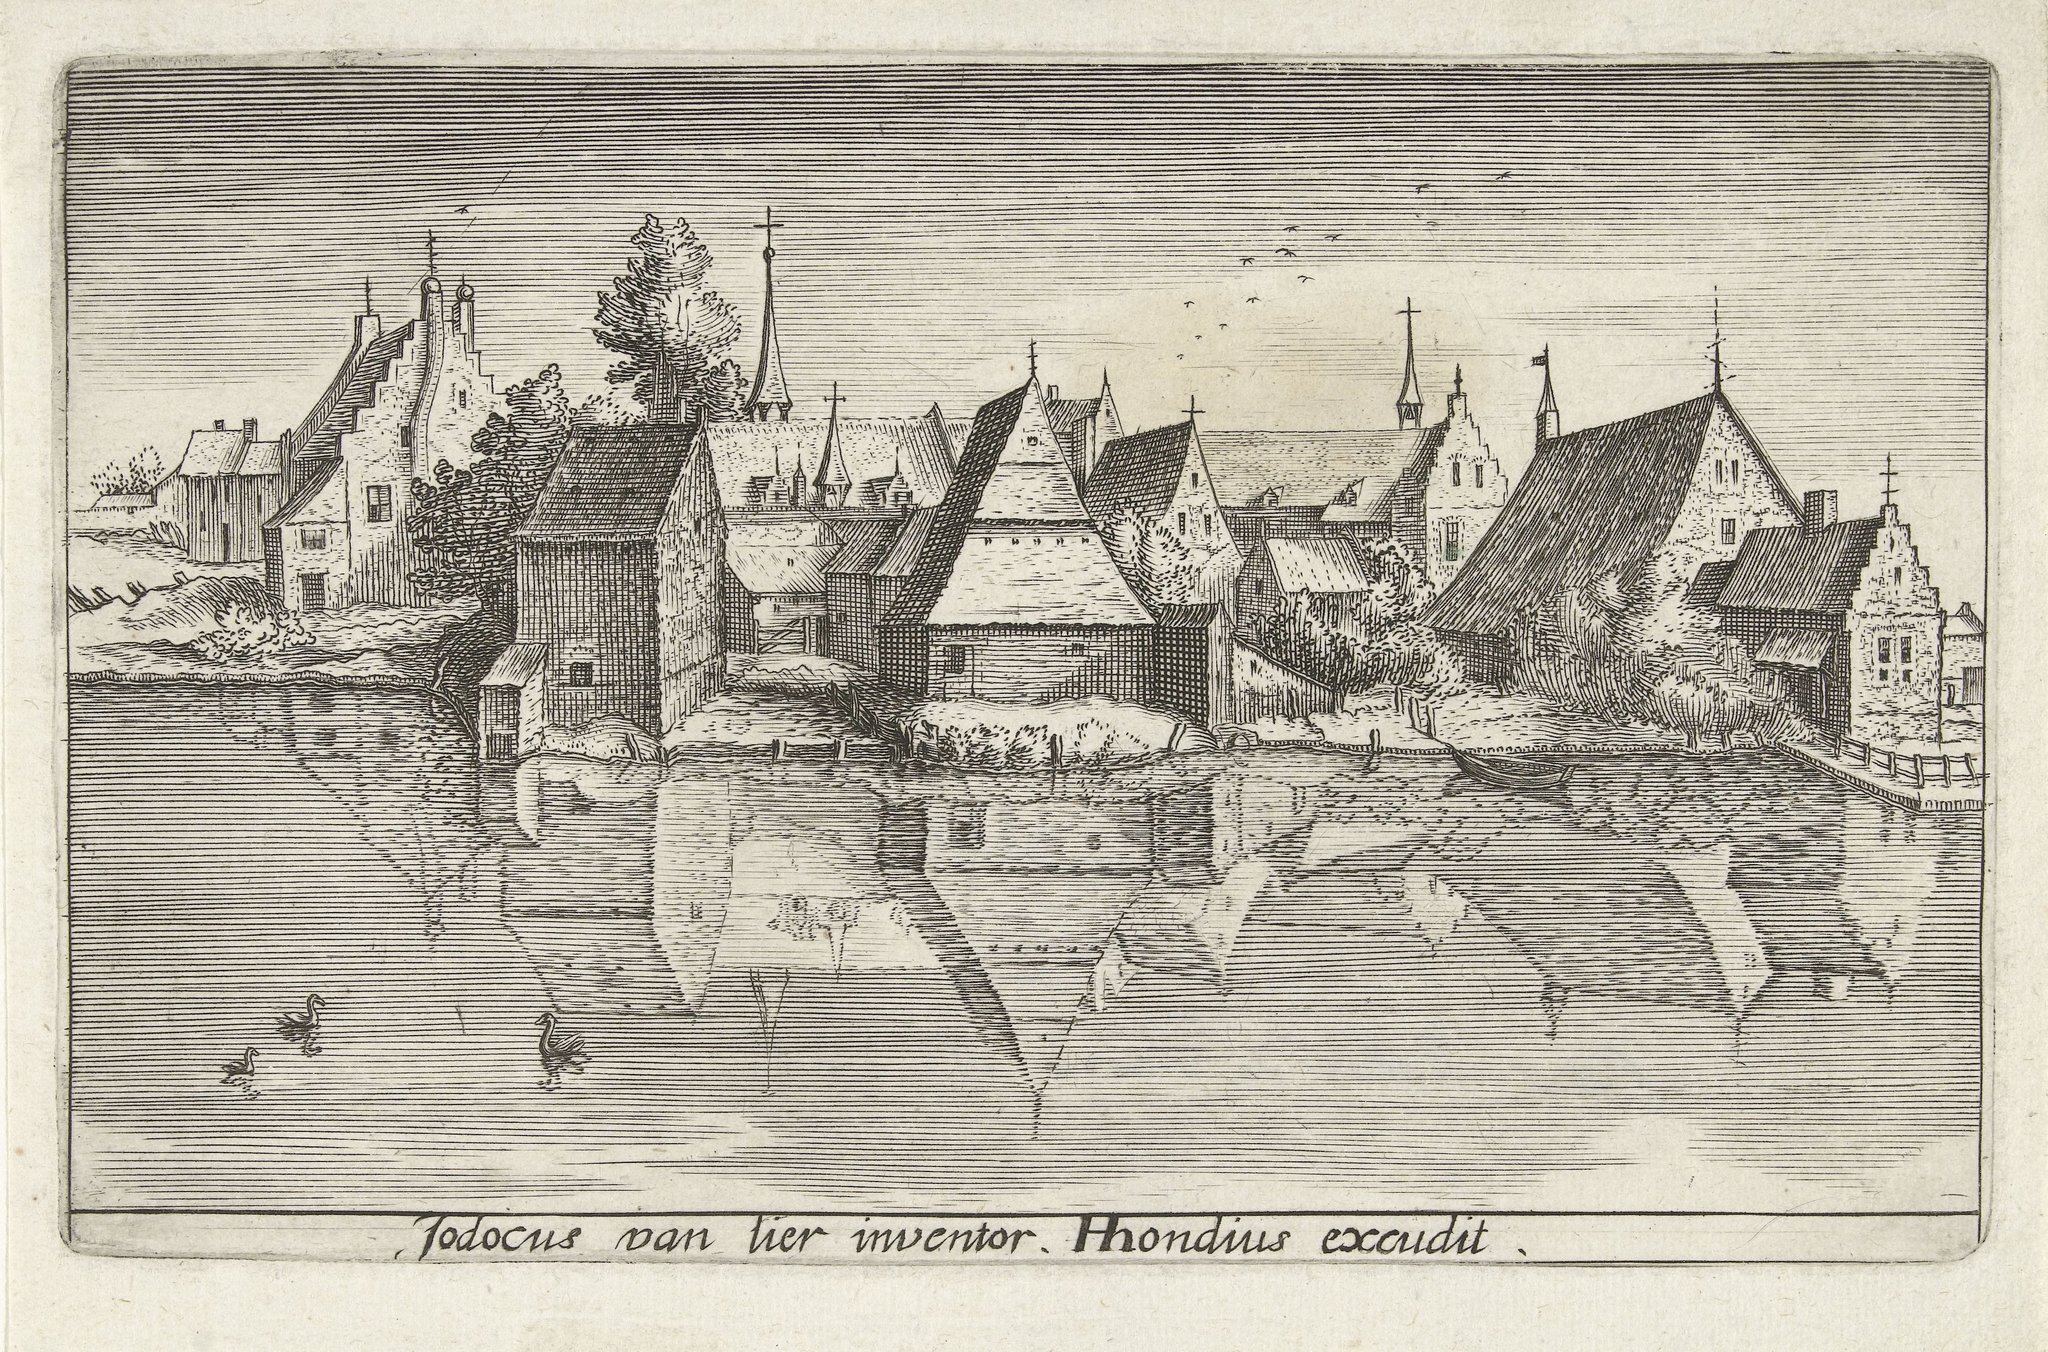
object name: print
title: Dorp aan een rivier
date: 1583-1650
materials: paper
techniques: etching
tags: village, reflection (light in general)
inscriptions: collector's mark: Lugt 2228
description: Gezicht op een dorp aan een waterkant. De huizen van het dorp worden weerspiegeld in het water op de voorgrond. Links zwemmen drie zwanen.